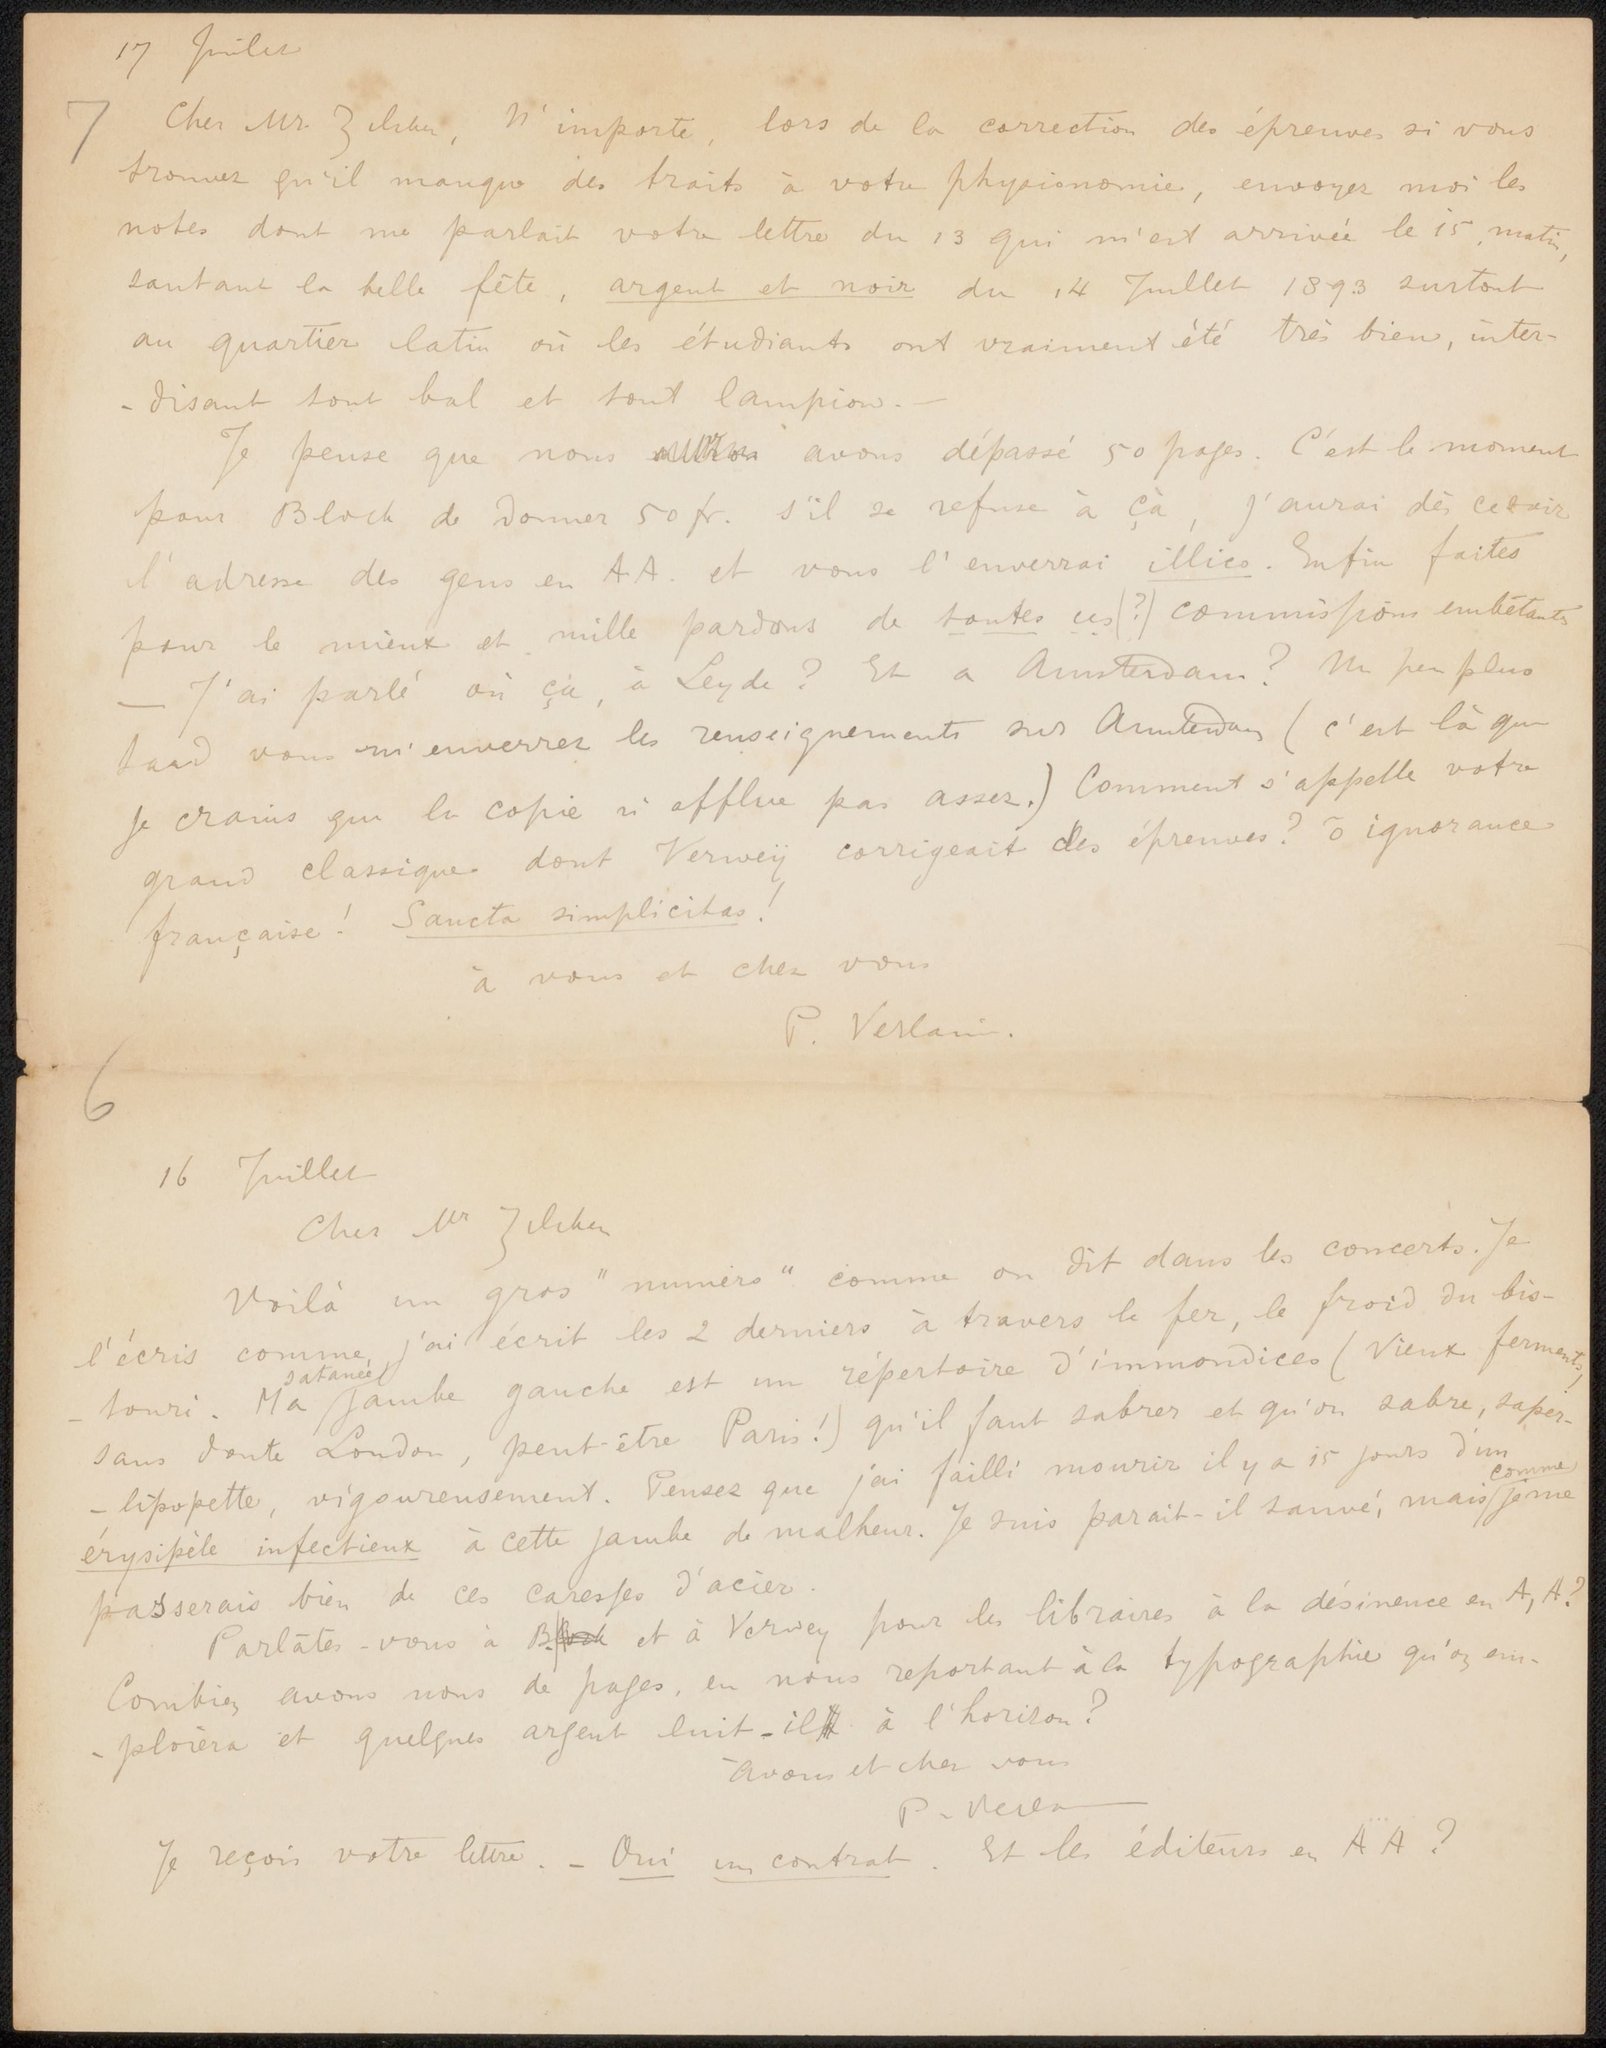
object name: letter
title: Brief aan Philip Zilcken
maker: paul verlaine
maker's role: dichter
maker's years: 1844-1896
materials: ink, paper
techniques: pen, printing, writing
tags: amsterdam, albert verwey, the hague, painter, draughtsman, philip zilcken, money, leiden, london, paris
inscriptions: collector's mark: ‘RPK’